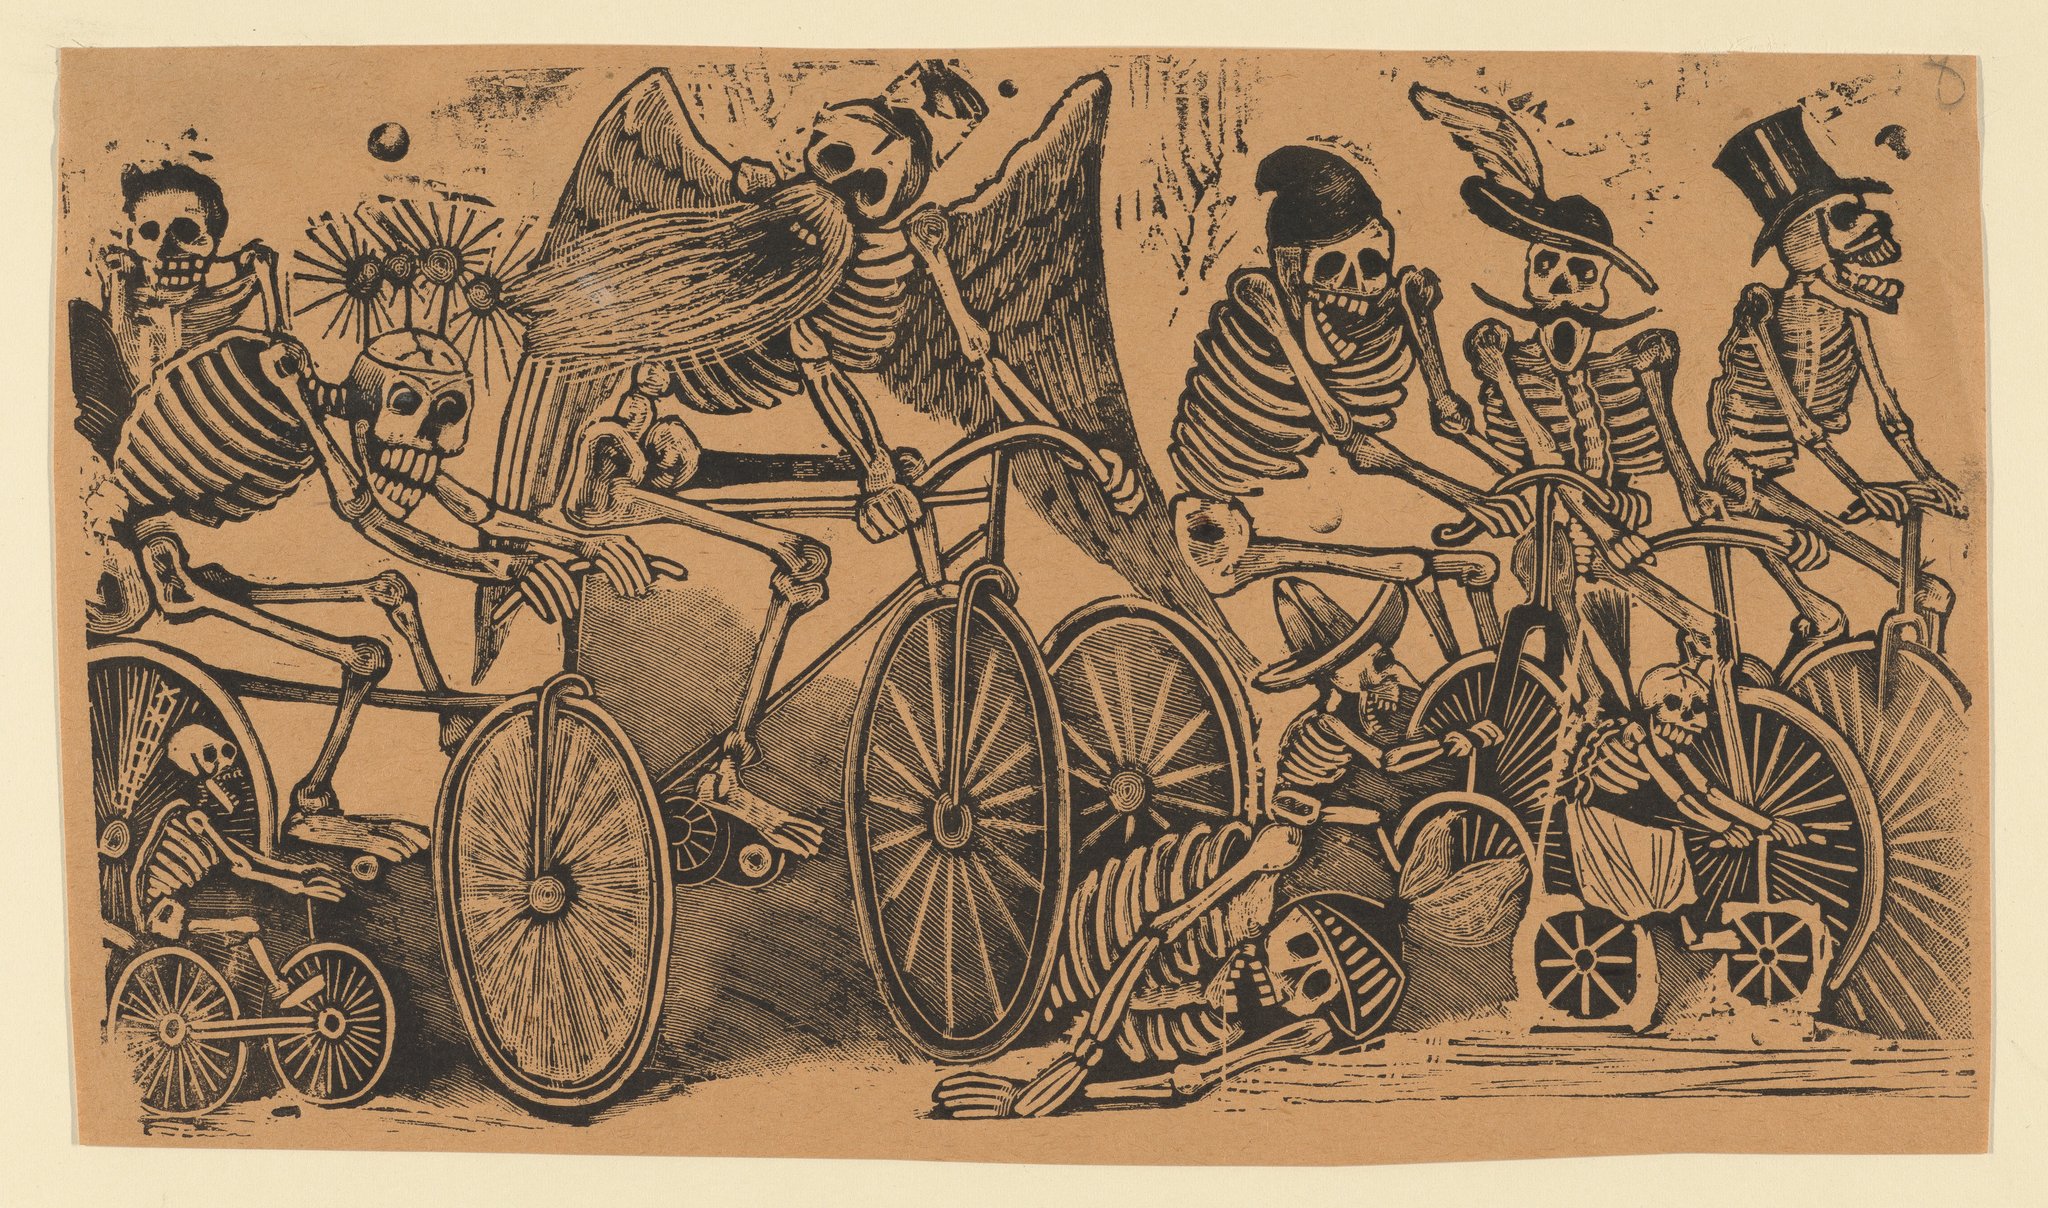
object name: print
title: Skeletons (calaveras) riding bicycles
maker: josé guadalupe posada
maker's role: artist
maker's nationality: mexican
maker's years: 1852-1913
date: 1891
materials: metal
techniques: engraving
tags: skeletons,bicycles